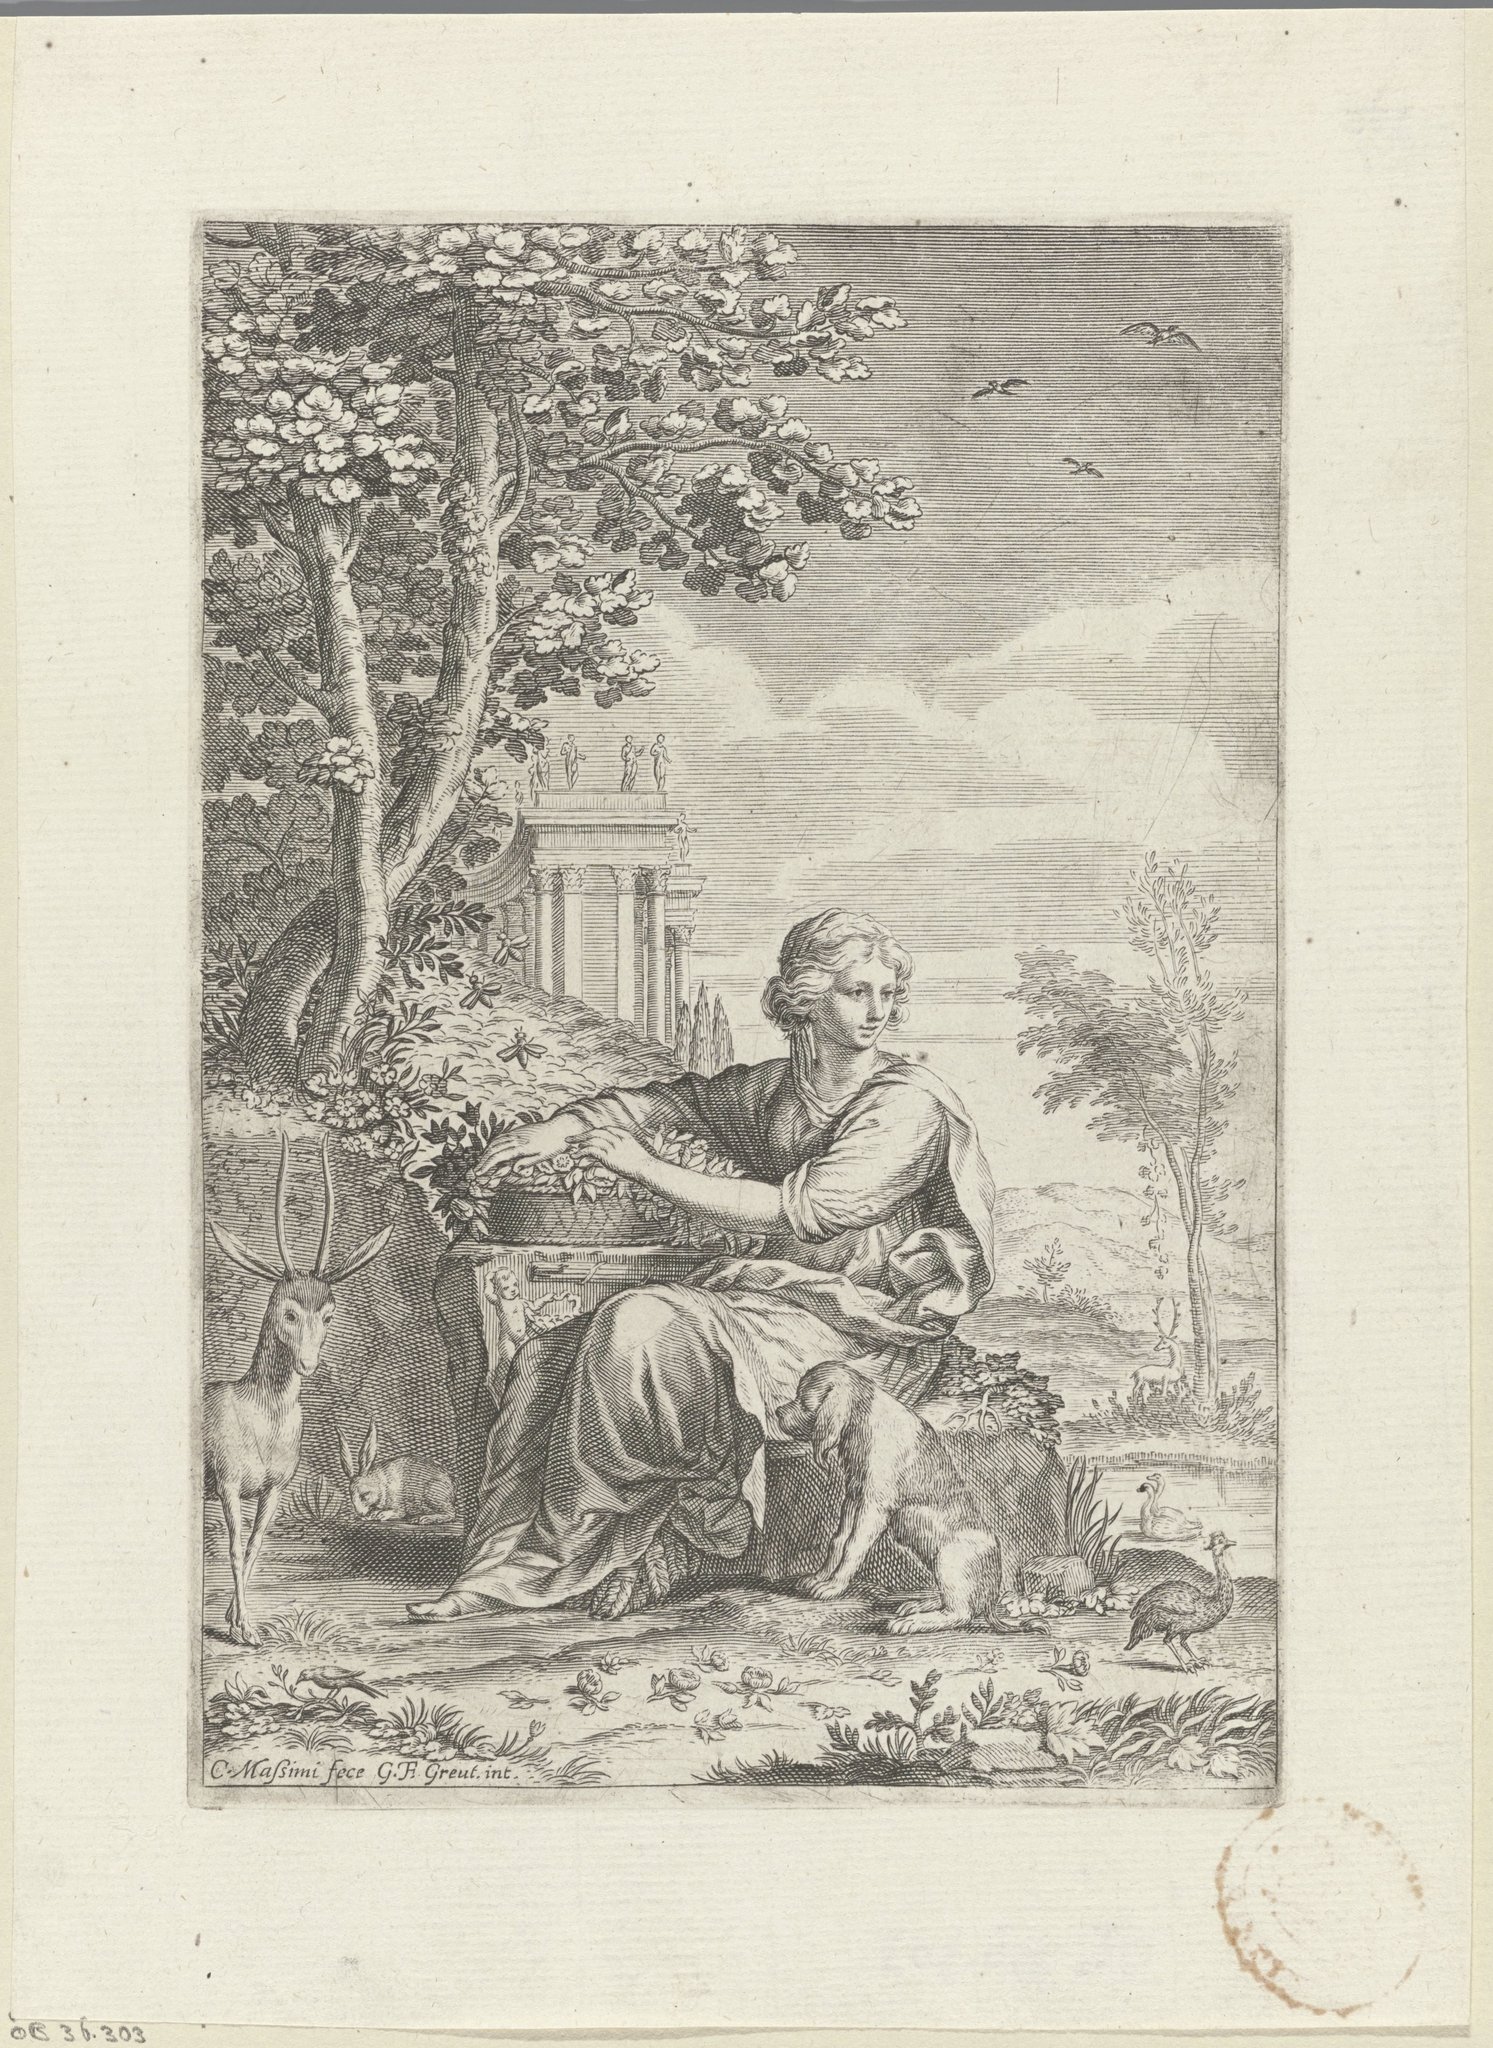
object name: book illustration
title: Gloria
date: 1640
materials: paper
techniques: engraving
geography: italy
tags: animals, (story of) flora, honour, glory; 'ampiezza della gloria', 'gloria', 'gloria de prencipi', 'gloria & honore', 'honore', 'sublimatà della gloria' (ripa)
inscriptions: collector's mark: Lugt 240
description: Prent gebruikt in: Barberini, Francesco. Docvmenti d'Amore/di M. Francesco/Barberini. At end: IN ROMA/ Nella Stamperia di Vitale Mascardi: 1640 (voor pagina 309).